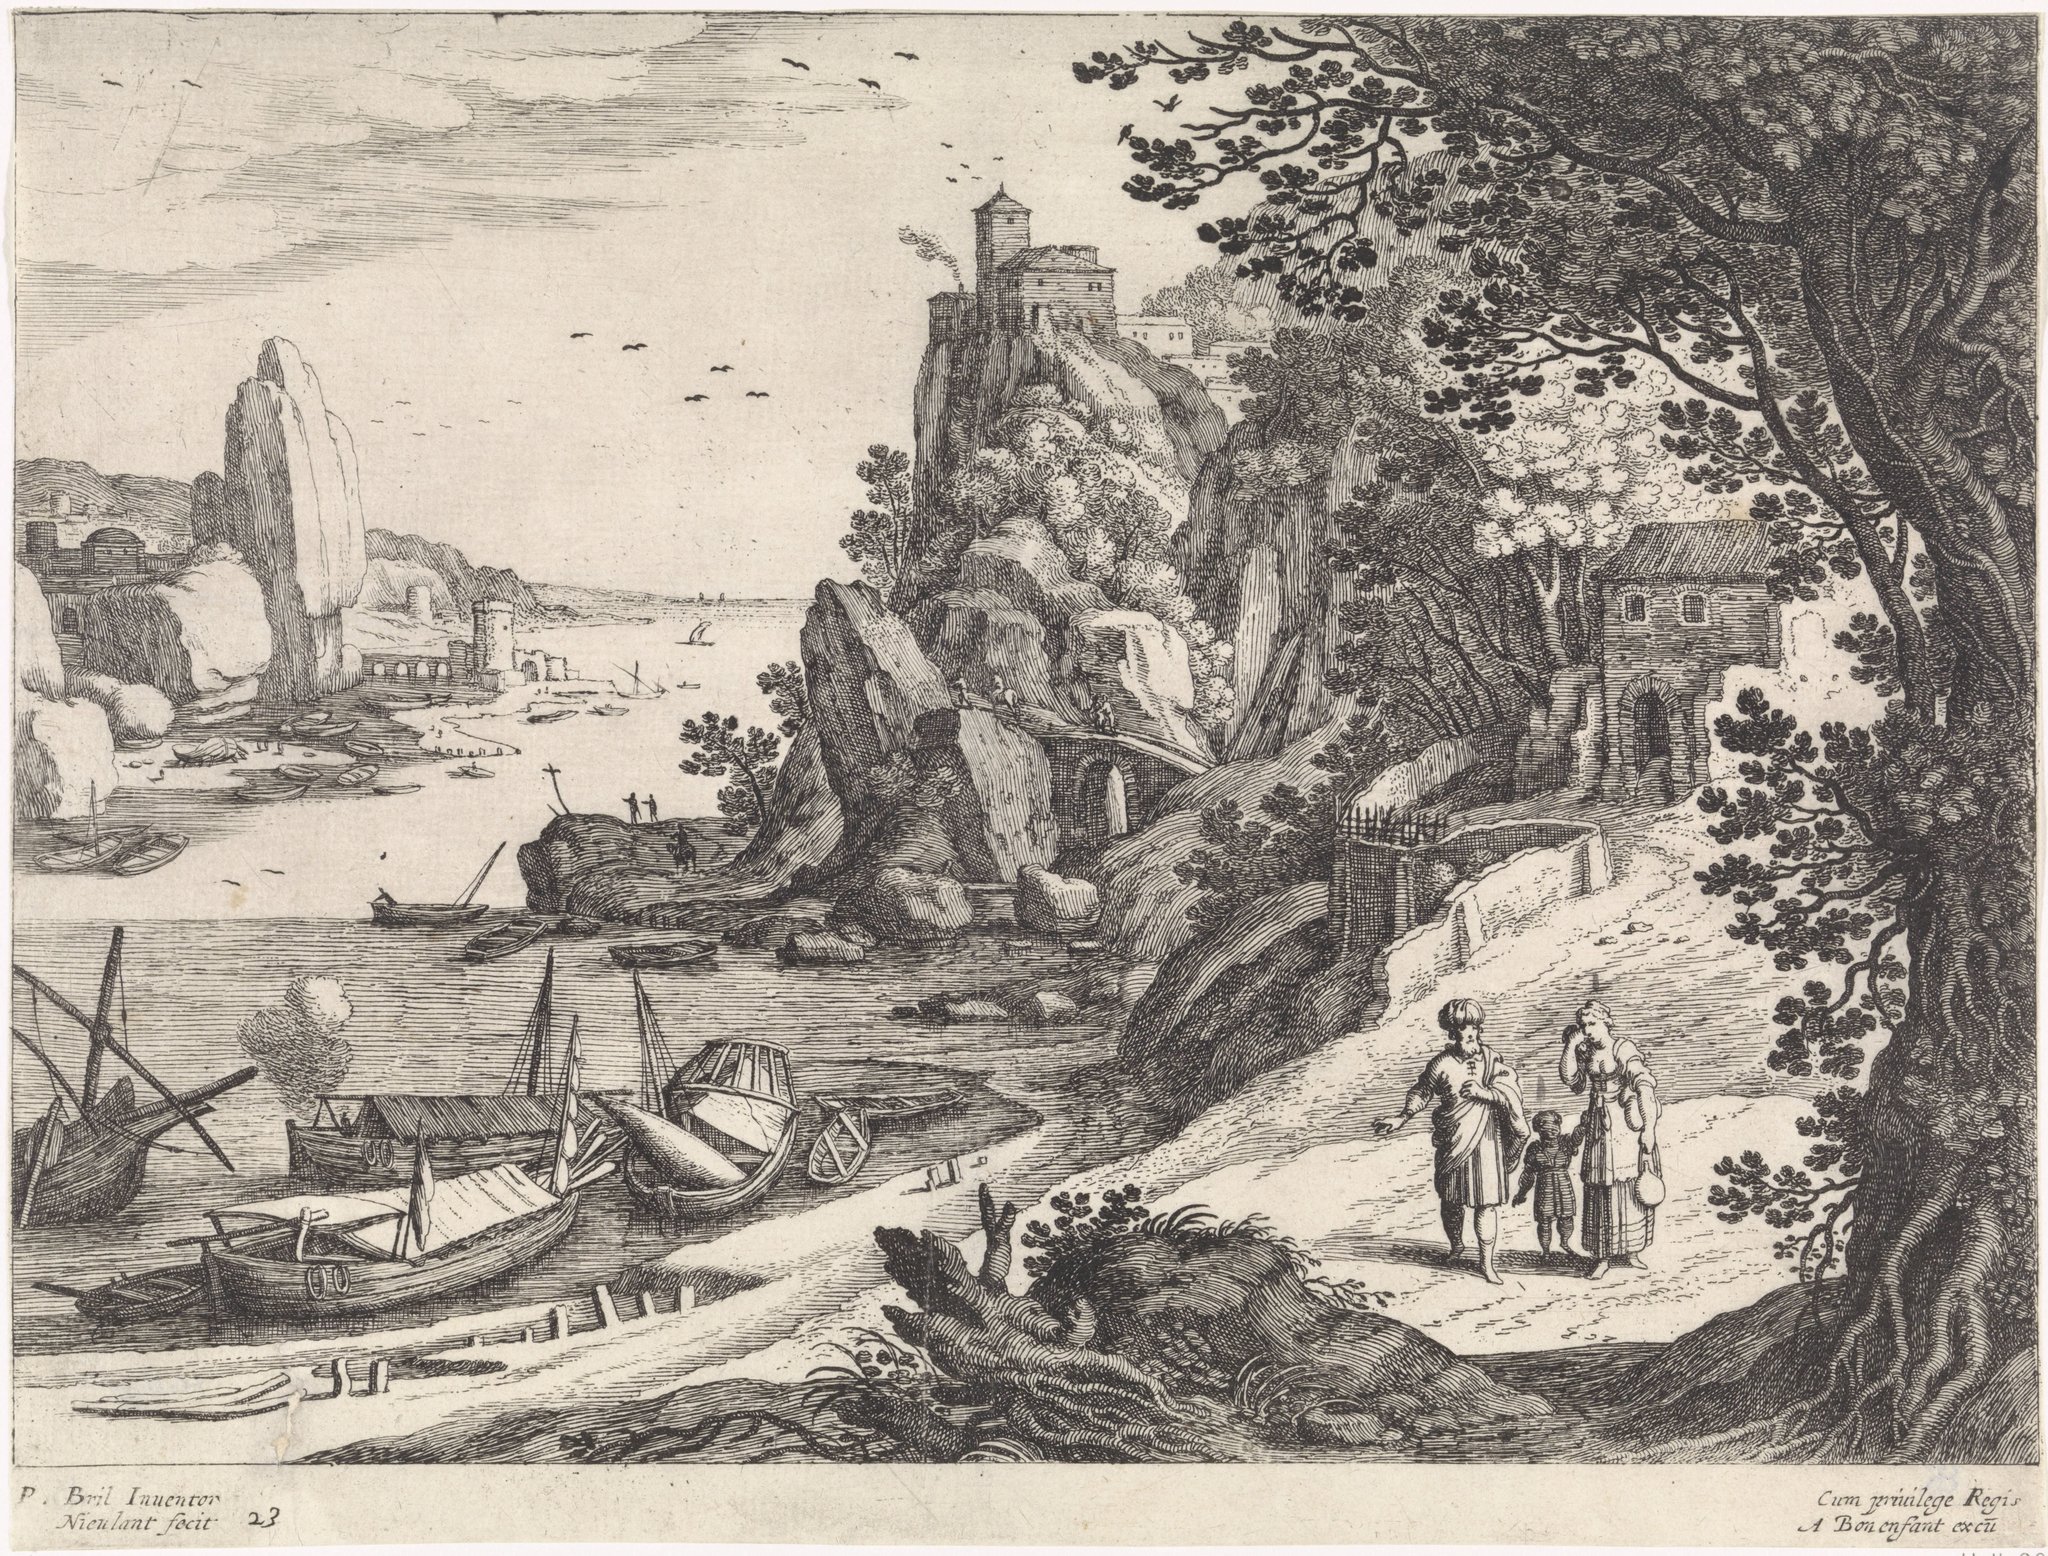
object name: print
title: Landschap met de verdrijving van Hagar en Ismaël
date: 1594-1635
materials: paper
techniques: engraving, etching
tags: gulf, bay, the banishment of hagar and ishmael (genesis 21:9-21), rocky coast, rowing-boat, canoe, etc.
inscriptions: collector's mark: Lugt 2228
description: In een Italiaans landschap staat Abraham naast Hagar en Ismaël. Hagar heeft een kruik in haar ene hand en houdt met haar andere hand een doek tegen haar gezicht. Op de achtergrond een baai met een rotsachtige kust. In het water liggen schuiten. Prent uit een serie Italiaanse landschappen.